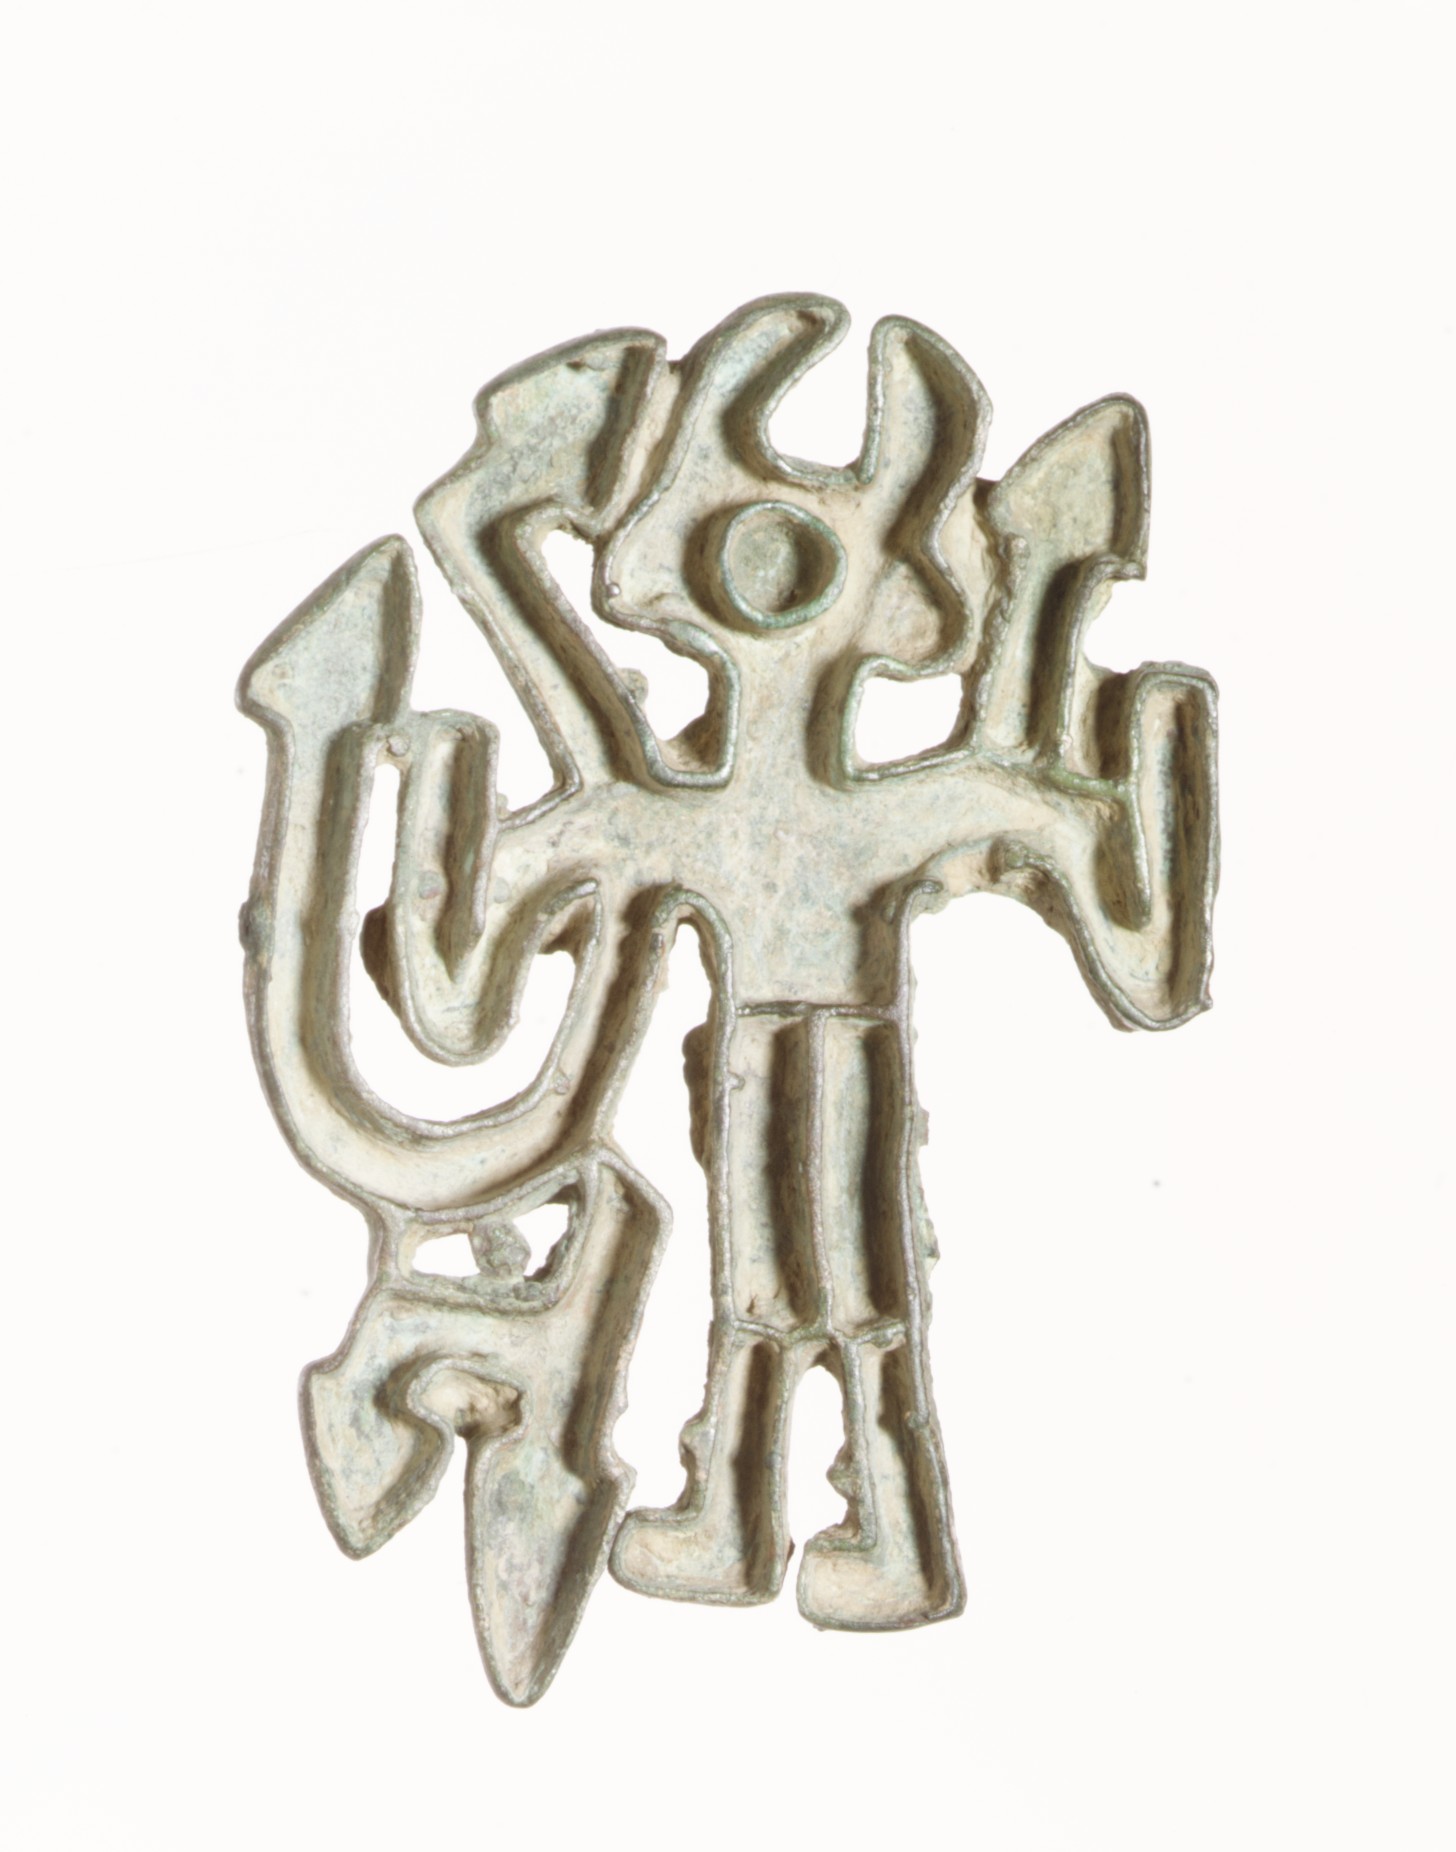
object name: stamp seal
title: Openwork stamp seal: figure holding snakes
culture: bactria-margiana archaeological complex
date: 2333-1668 BCE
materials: copper alloy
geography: bactria-margiana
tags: snakes